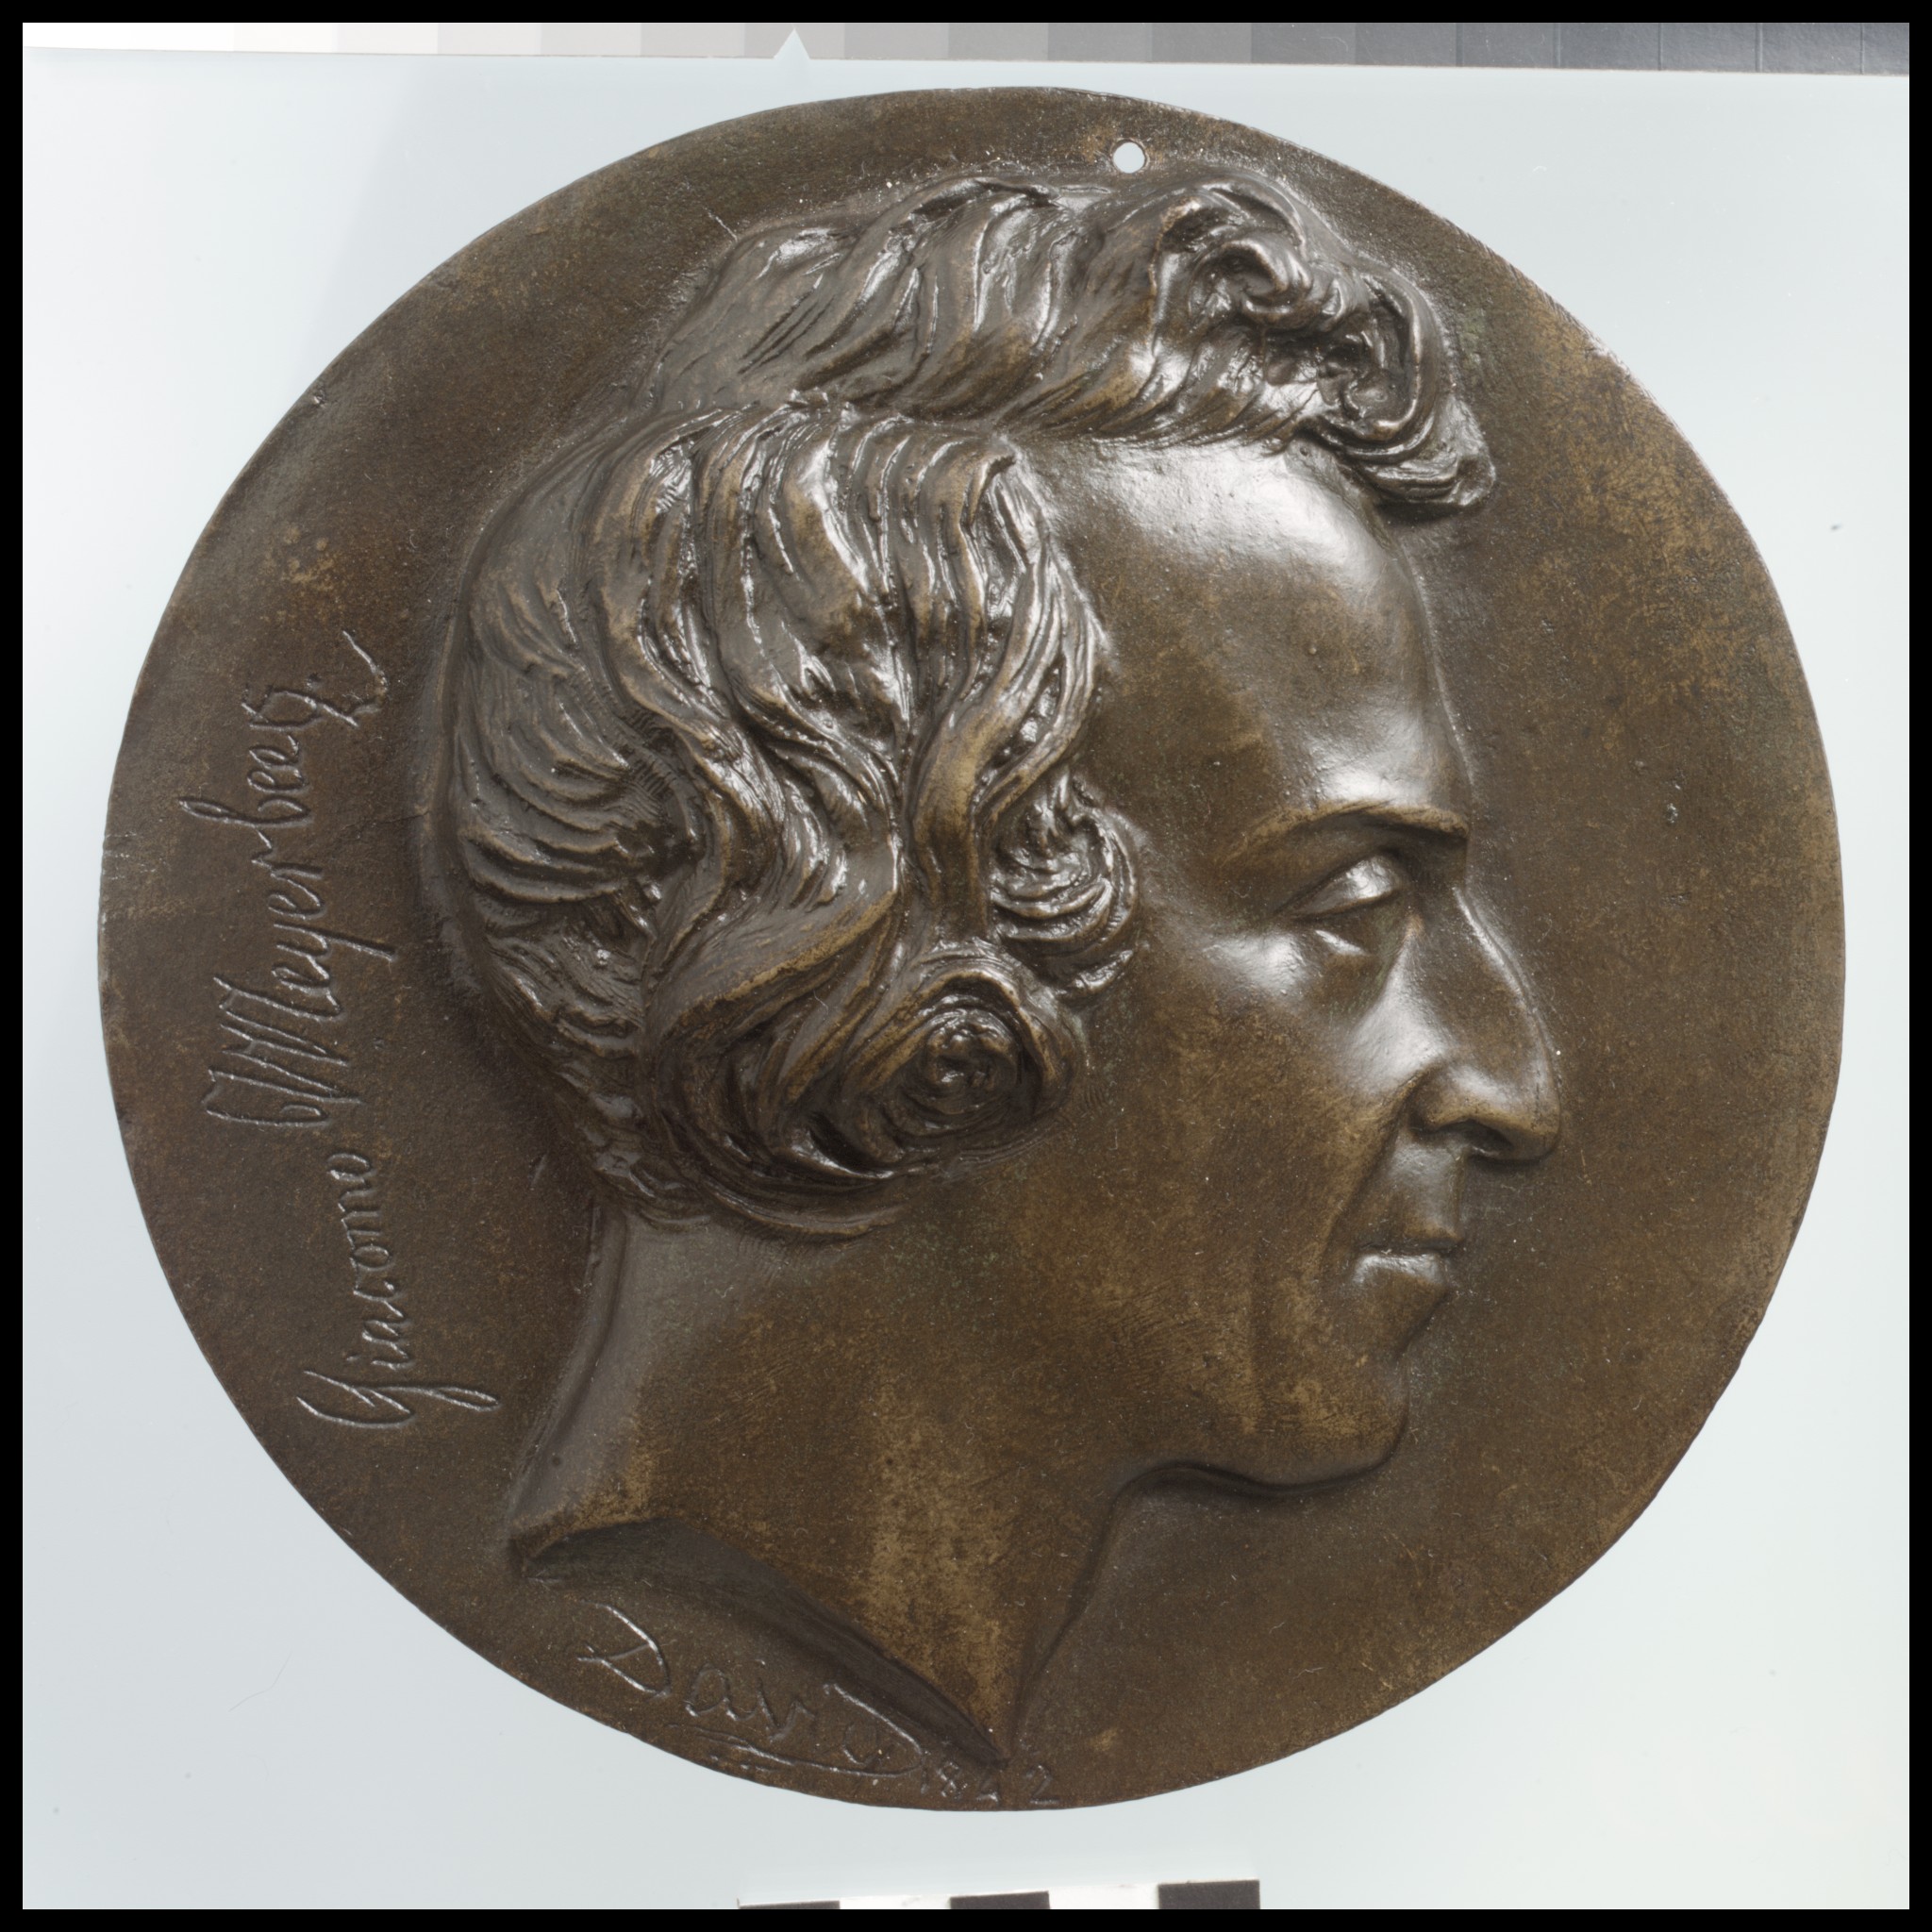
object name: medallion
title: Giacomo Meyerbeer (1791–1842)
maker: pierre jean david d'angers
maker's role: artist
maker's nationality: french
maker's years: 1788-1856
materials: bronze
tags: men,profiles